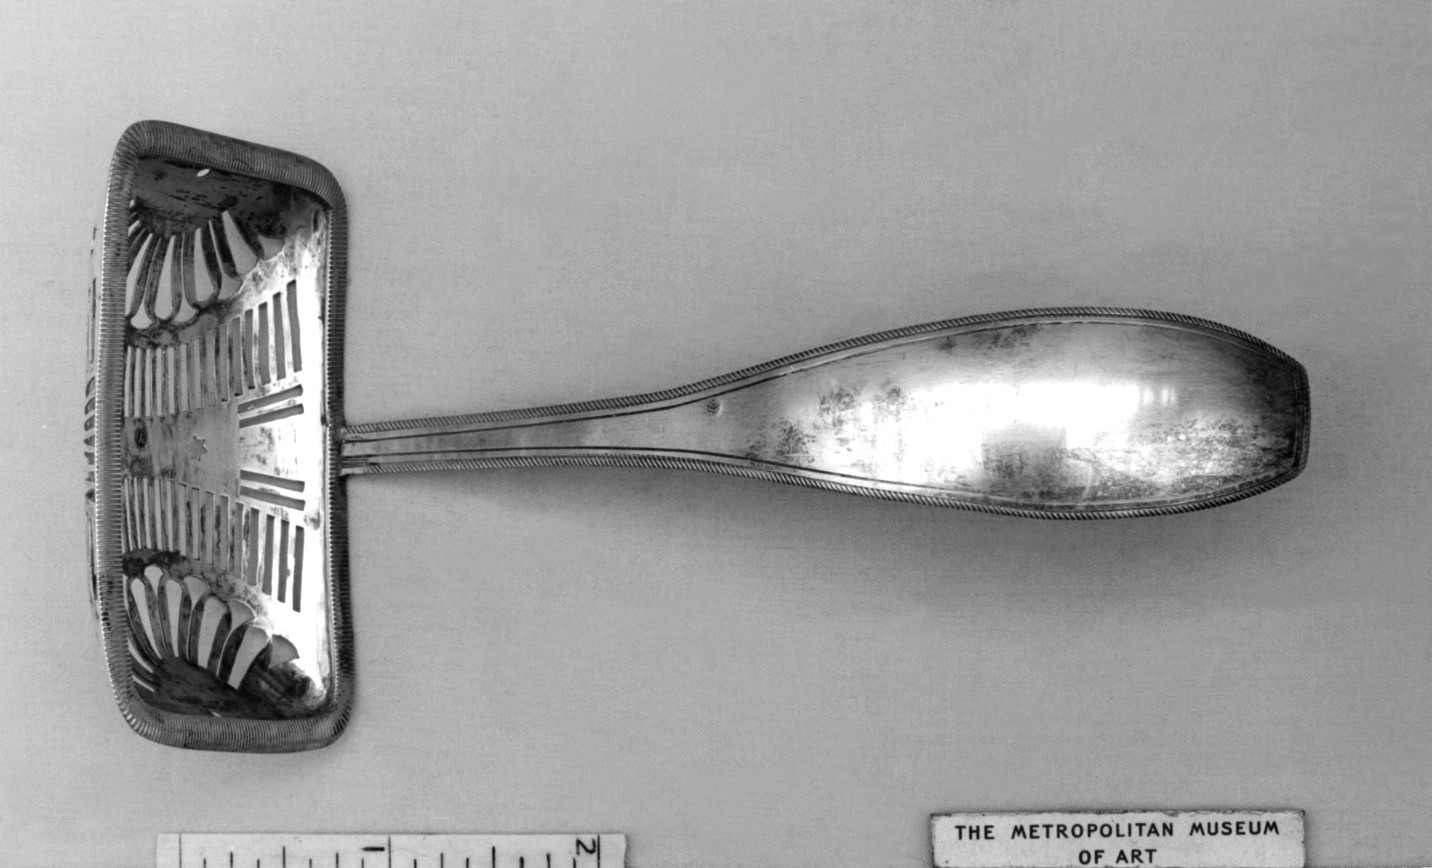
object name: sugar sifter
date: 1835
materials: silver